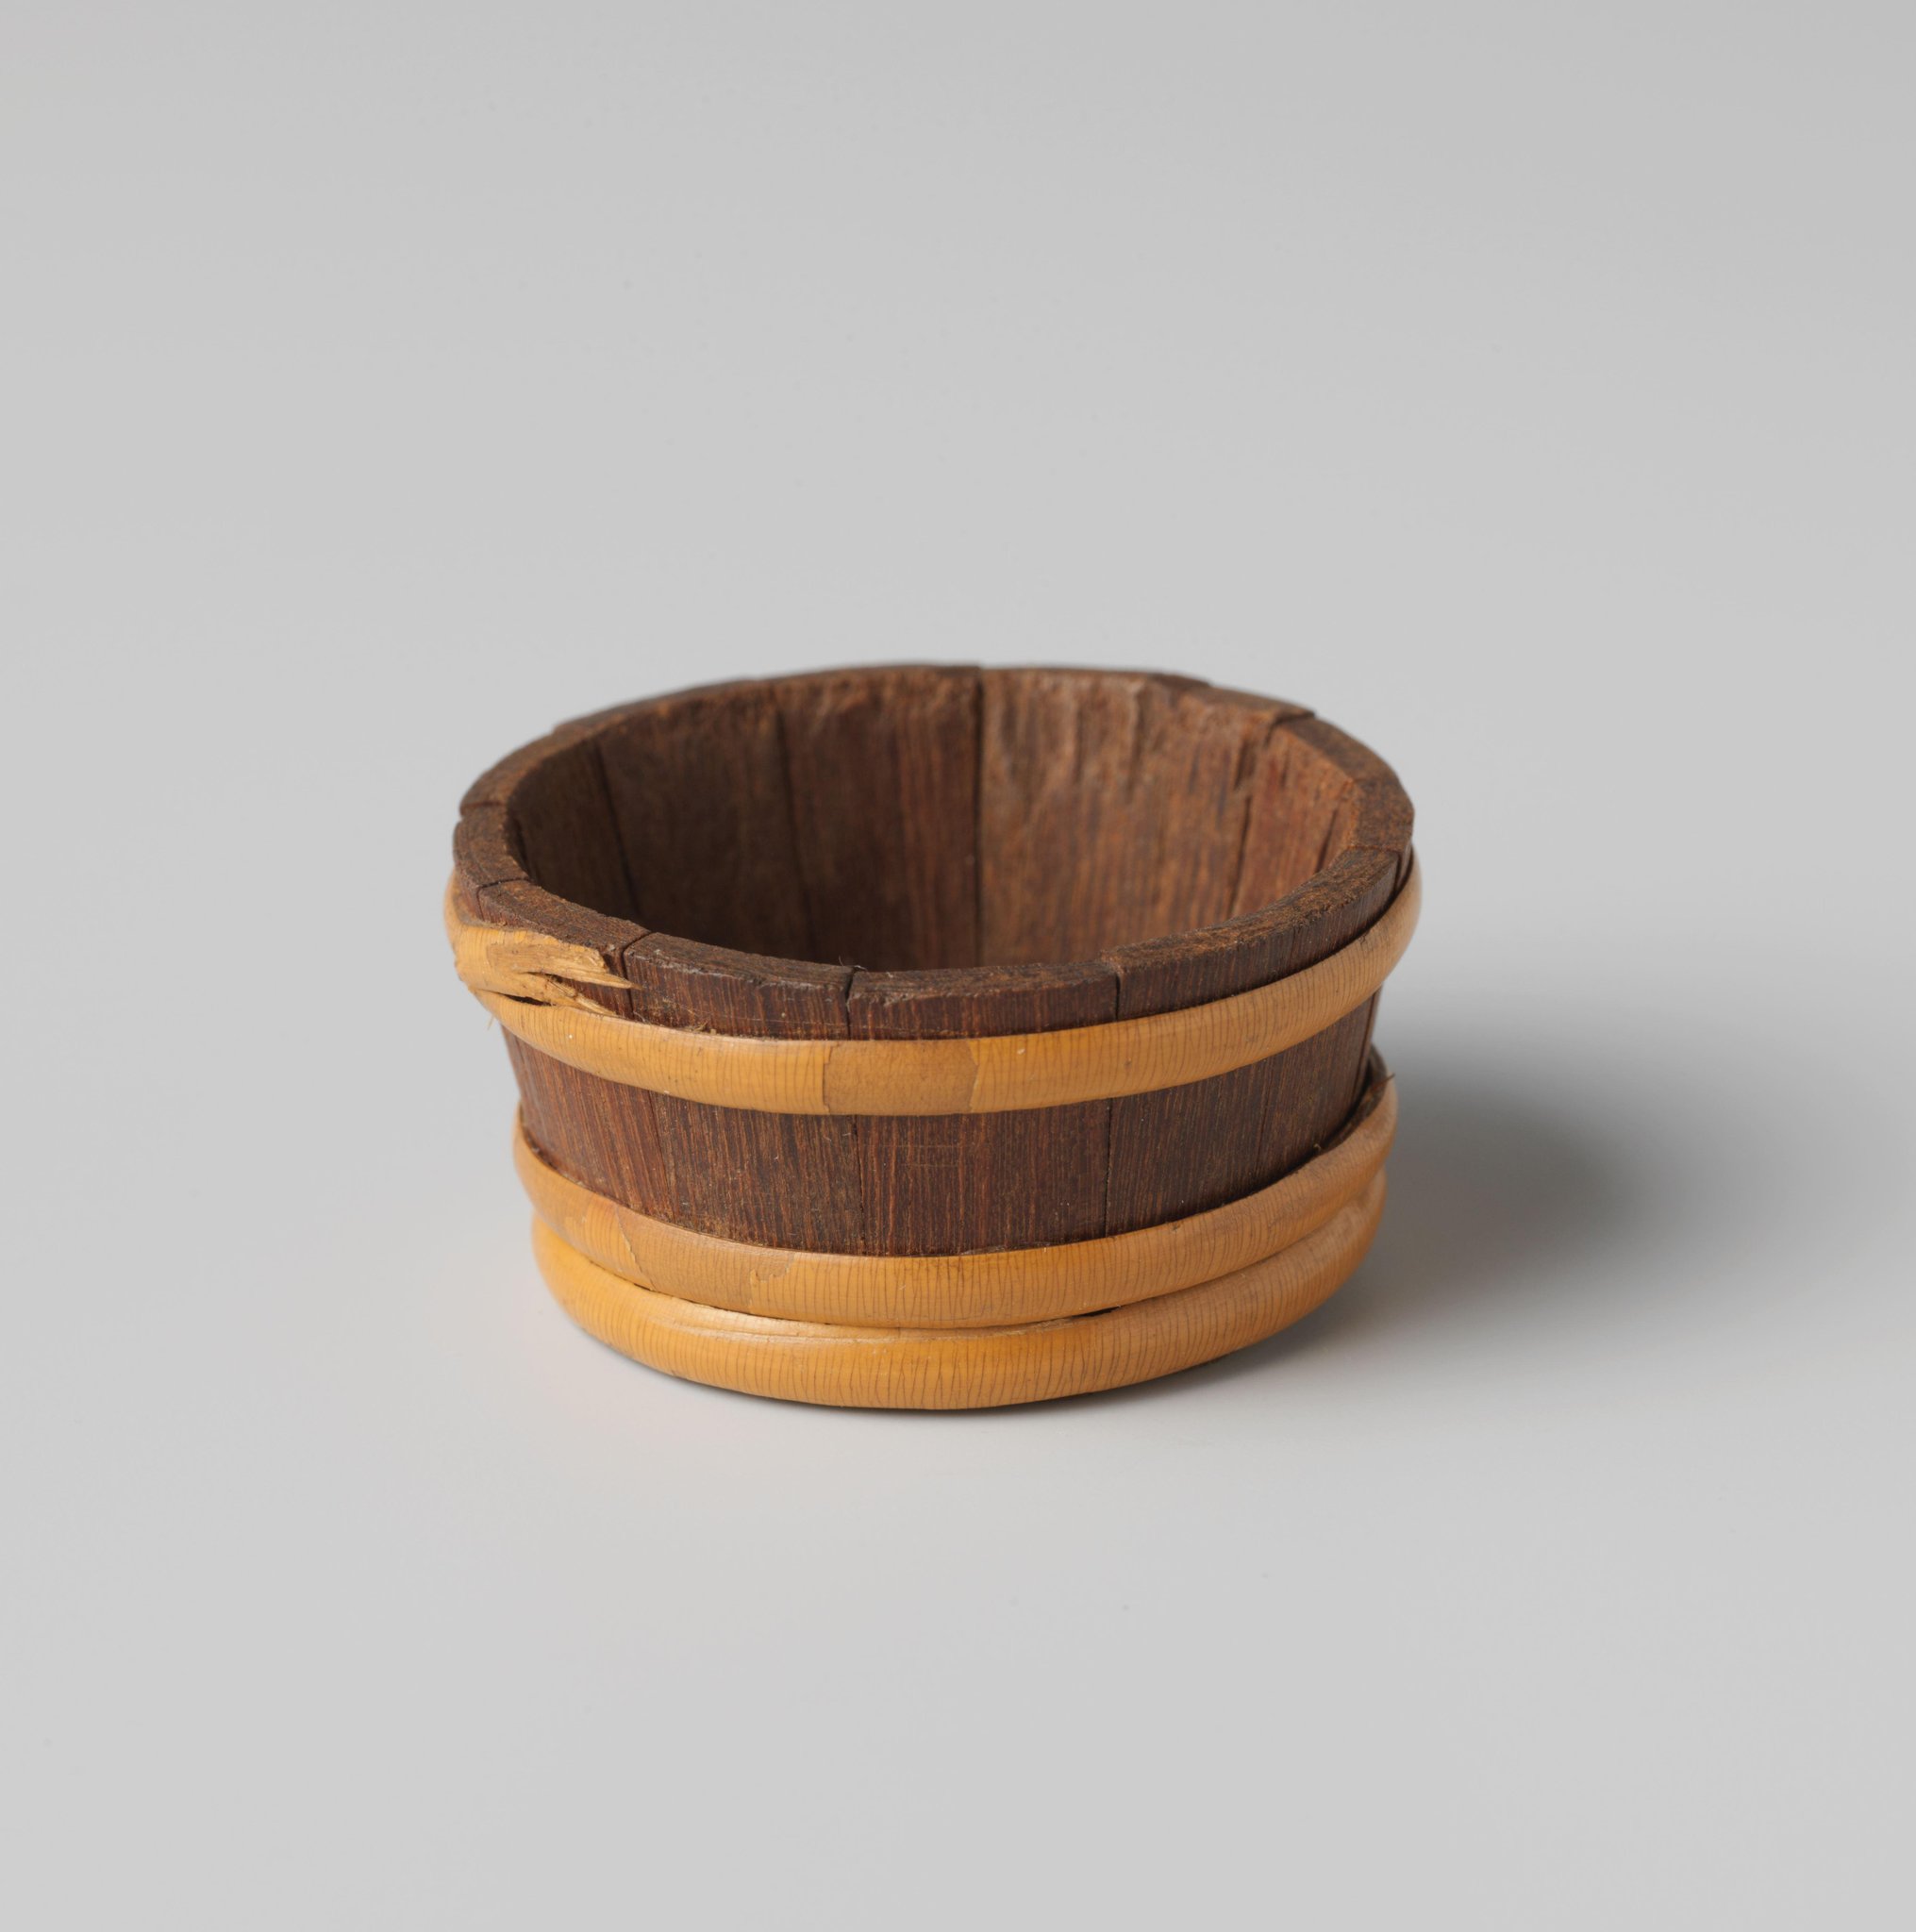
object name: lekbak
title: Tobbe of standring, vervaardigd van duigen omwonden met twee en drie hoepels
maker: Anonymous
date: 1700-1799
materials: rattan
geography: amsterdam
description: Standring of bodemloze tobbe of lekbak, gemaakt van losse duigen van een tropische hardhoutsoort (bolletrie ?) omwonden door twee en drie hoepels van rotan.